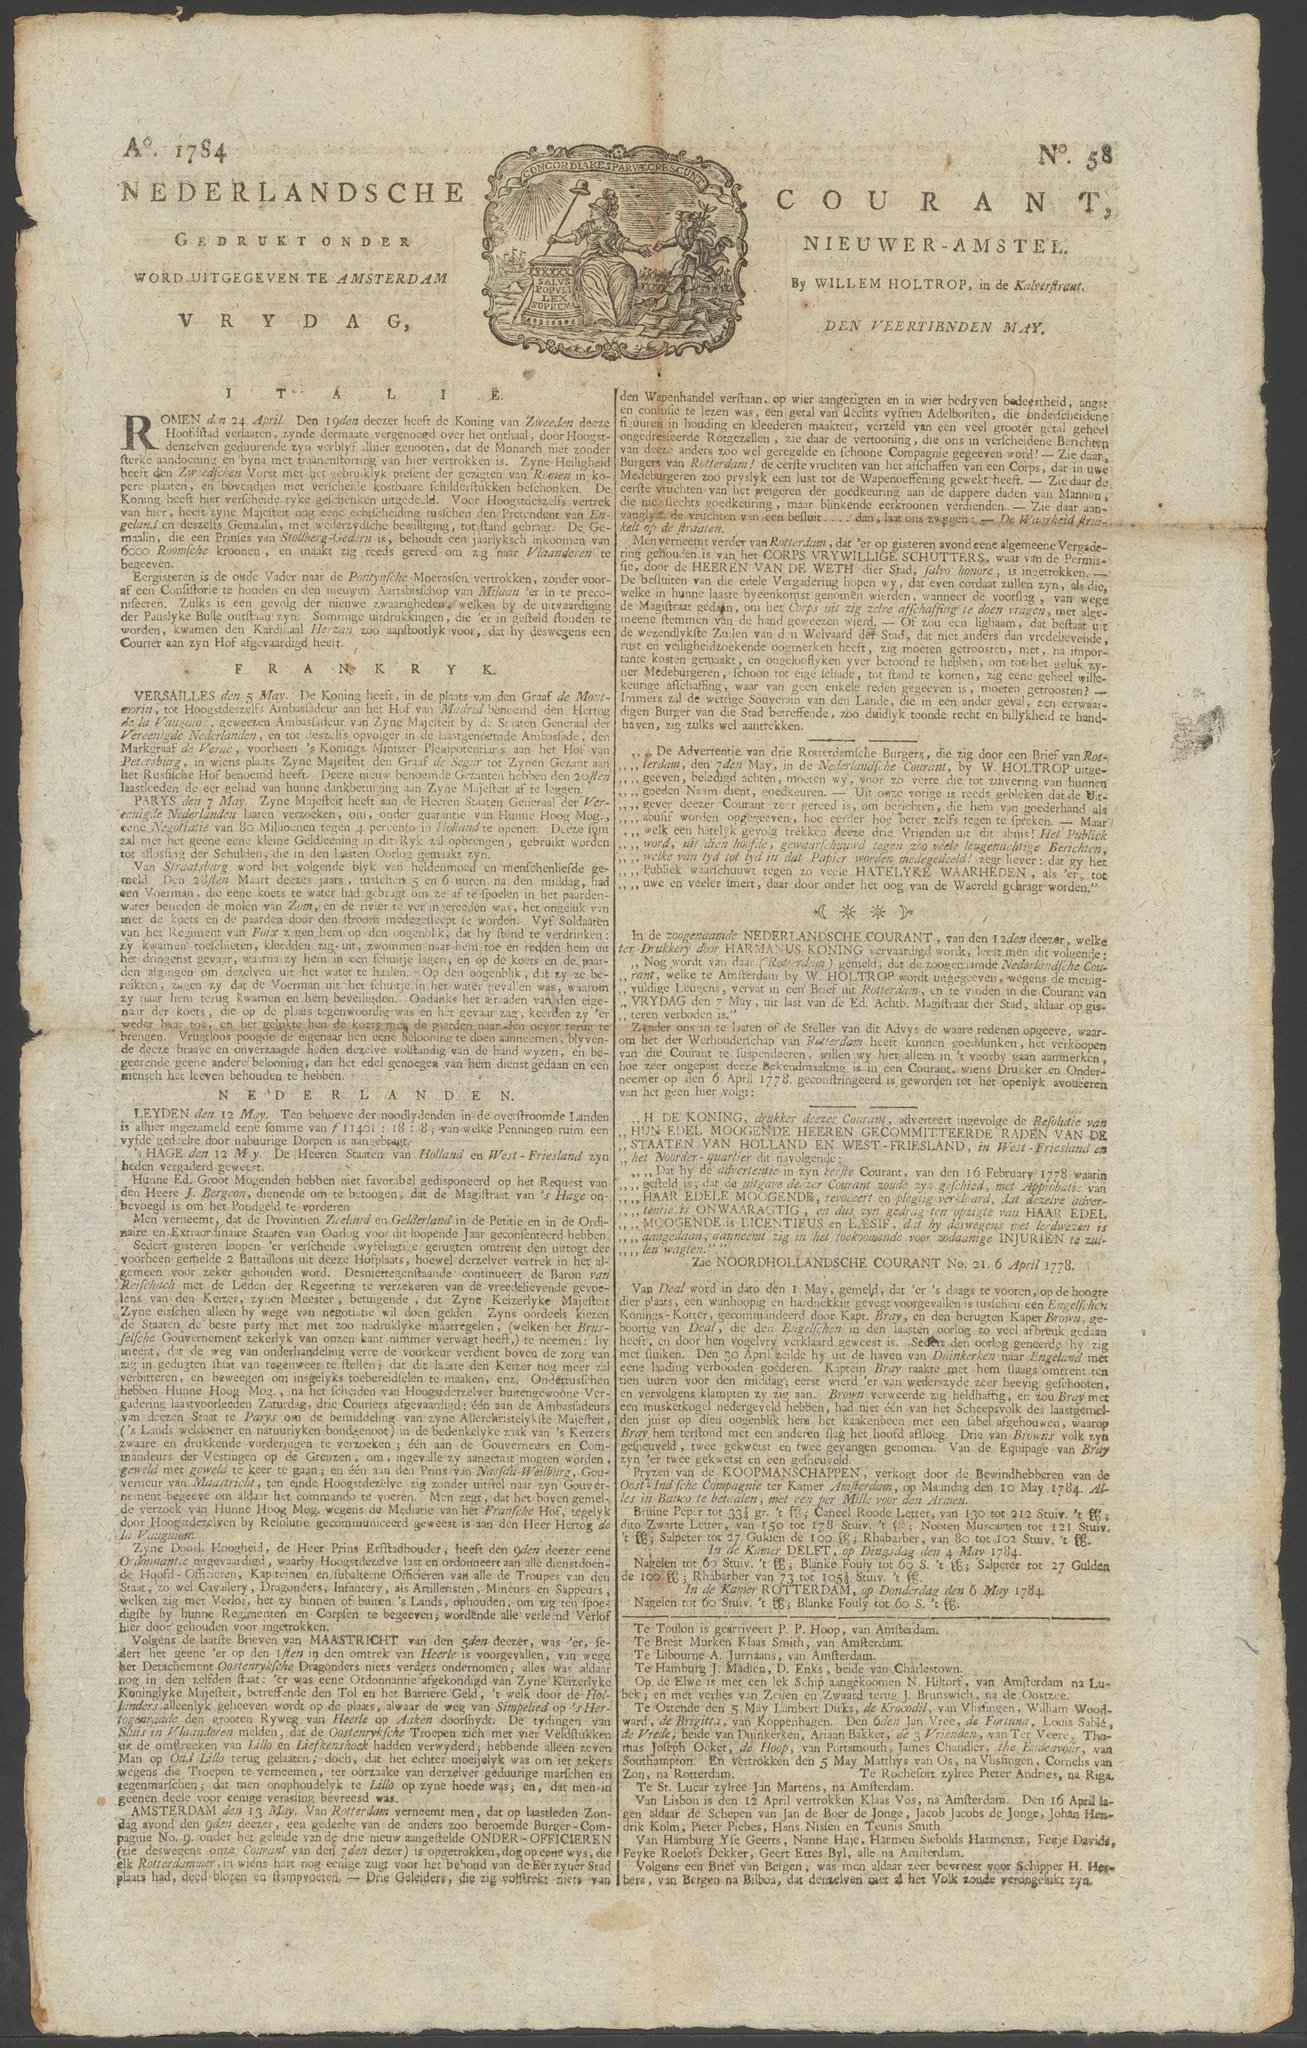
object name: newspaper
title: Nederlandsche Courant, 14 mei 1784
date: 1784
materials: paper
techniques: letterpress printing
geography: amsterdam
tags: newspaper, news-sheet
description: Exemplaar van de krant 'Nederlandsche Courant' van 14 mei 1784. Enkelbladig, beide zijden bedrukt. Bovenaan een vignet met de Vrijheid en Mercurius. Onderwerpsrubrieken binnen de Atlas Zeden en Gewoonten: Regeering, Officieele Nieuwsbladen.